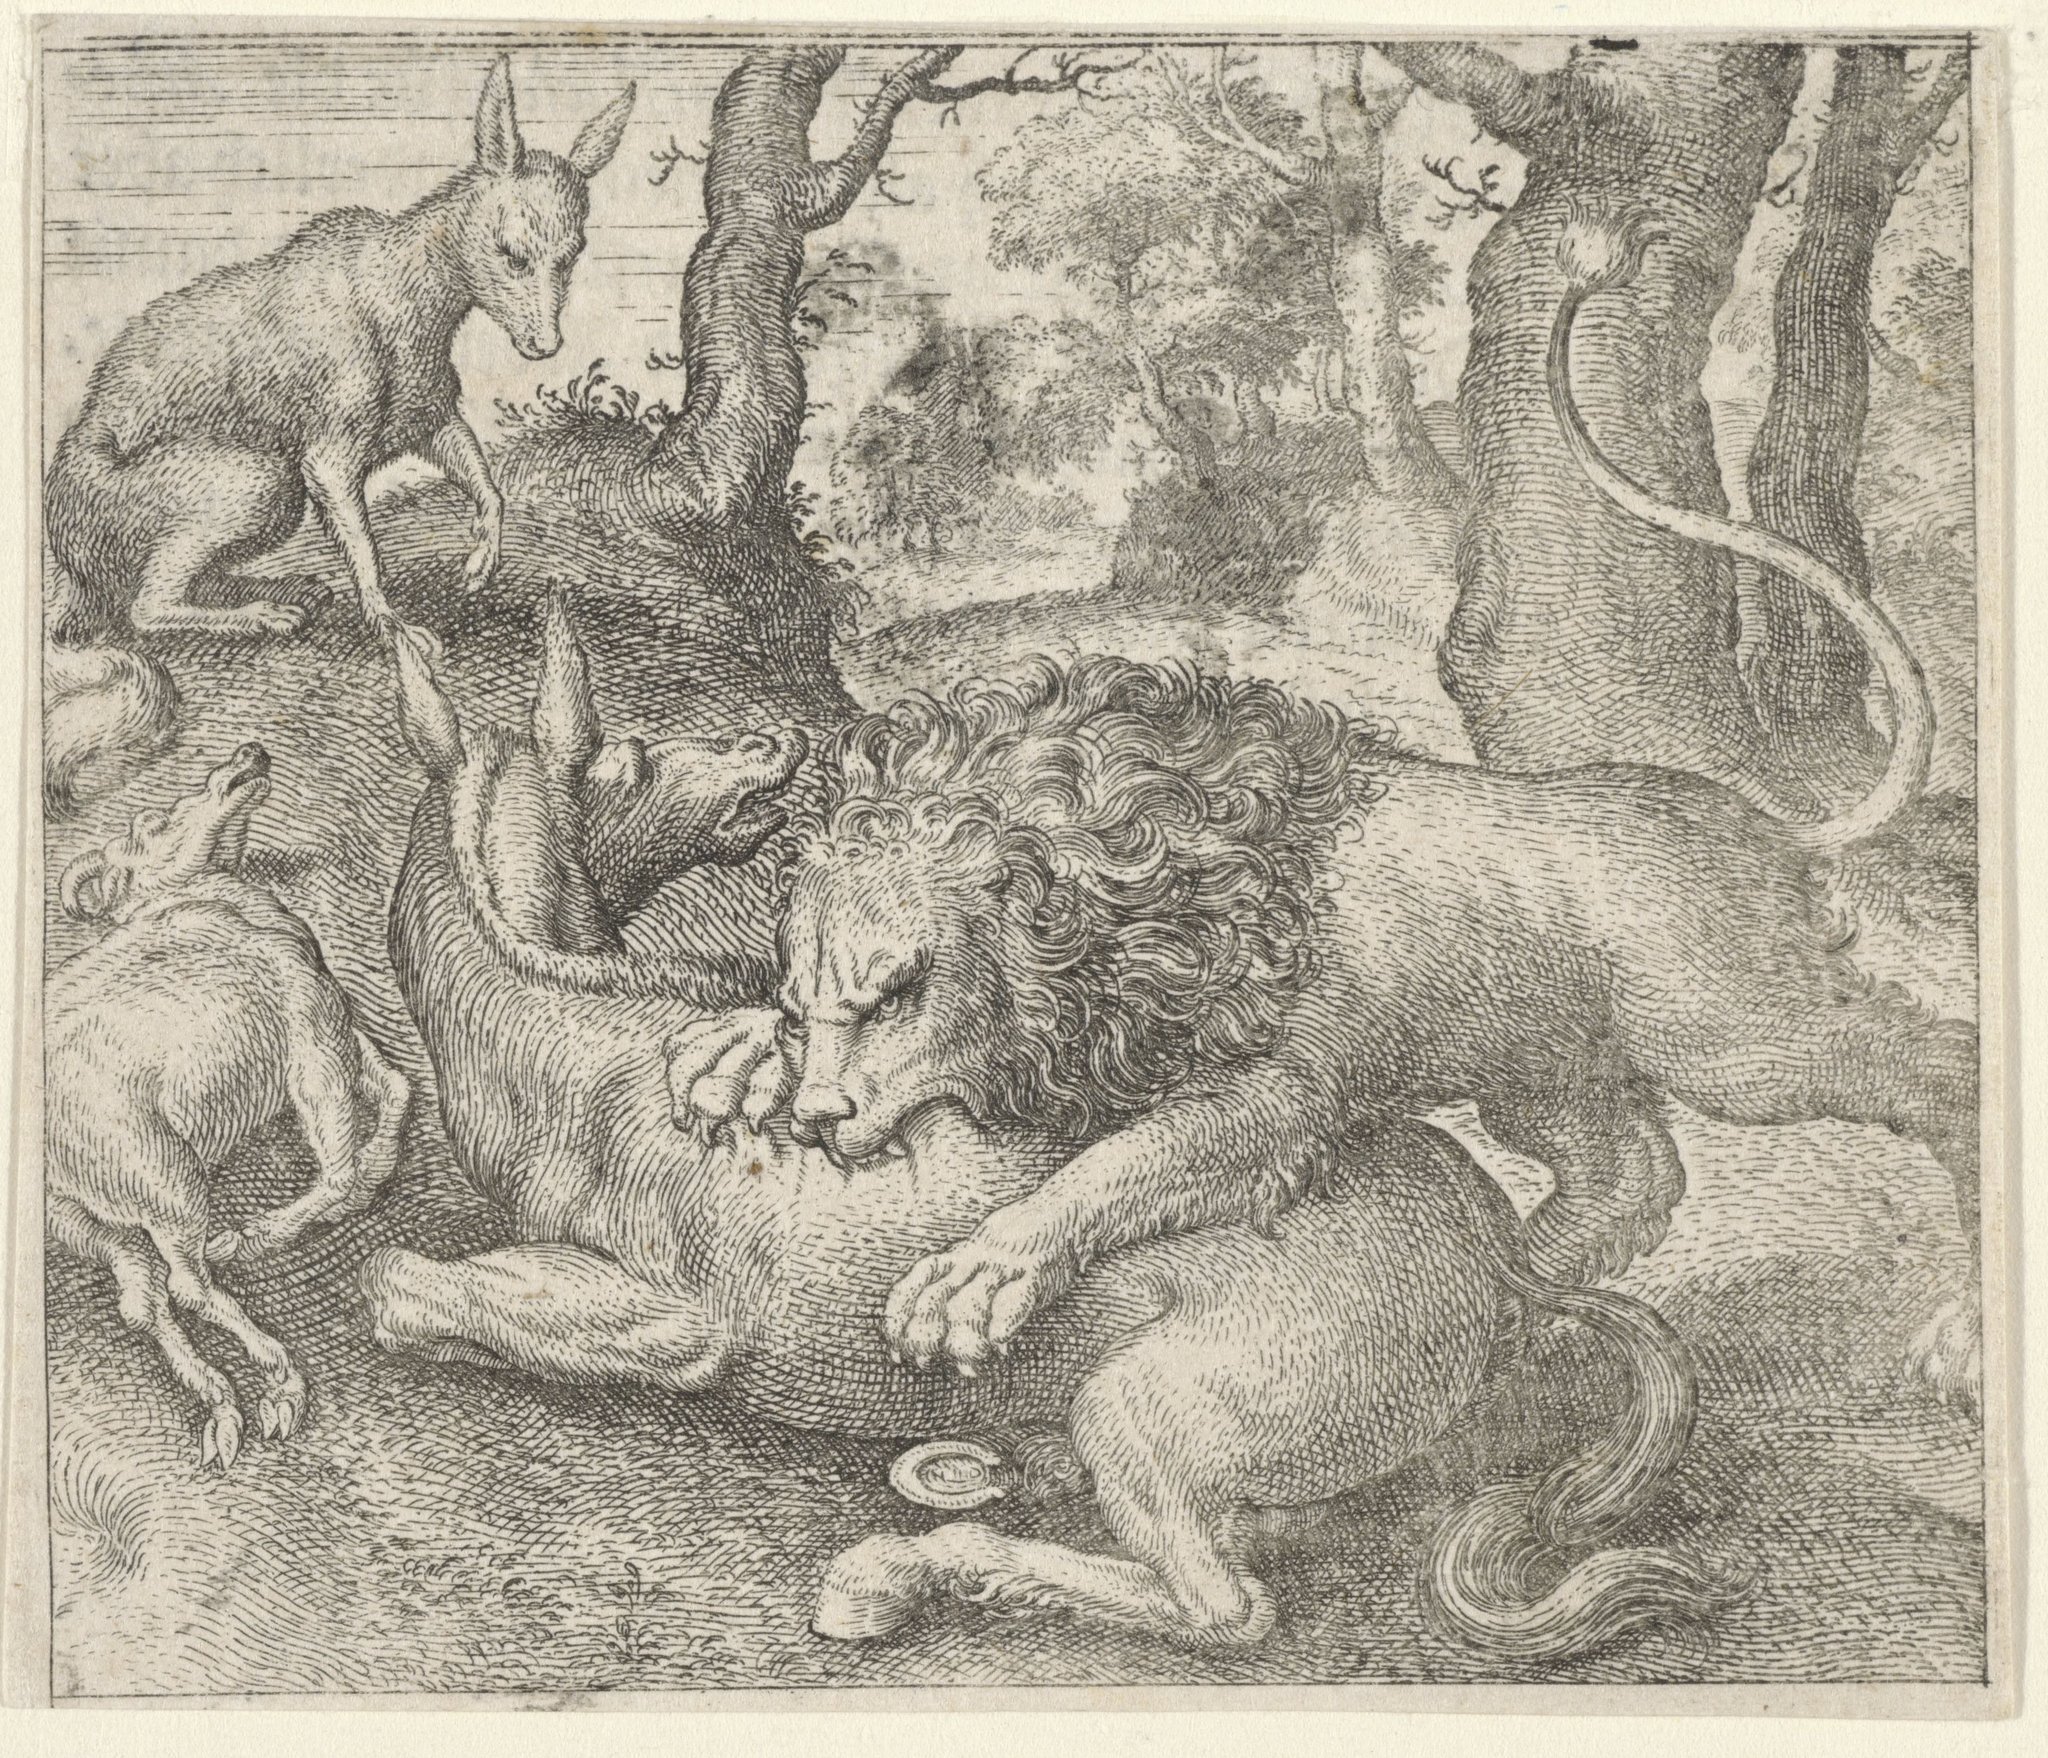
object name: print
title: Fabel van de leeuw en de vos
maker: aegidius sadeler (ii)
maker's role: draughtsman, print maker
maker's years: 1568-1629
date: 1608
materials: paper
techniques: engraving, etching, letterpress printing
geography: prague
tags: goat (+ dying animal; death of animal; dead animal), ass, donkey, fables, beasts of prey, predatory animals: lion, beasts of prey, predatory animals: fox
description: Een leeuw verslindt een ezel. Naast de ezel ligt een dode geit. Op een heuveltje kijkt een vos toe. De fabel beschrijft hoe koning leeuw alle dieren uitnodigt naar het paleis. De vos vertrouwt de leeuw niet en wacht voor de ingang van het paleis af. Hij ontdekt dat geen van de andere dieren het paleis terug verlaat. De moraal van het verhaal leert dat men tirannieke vorsten nooit mag vertrouwen.